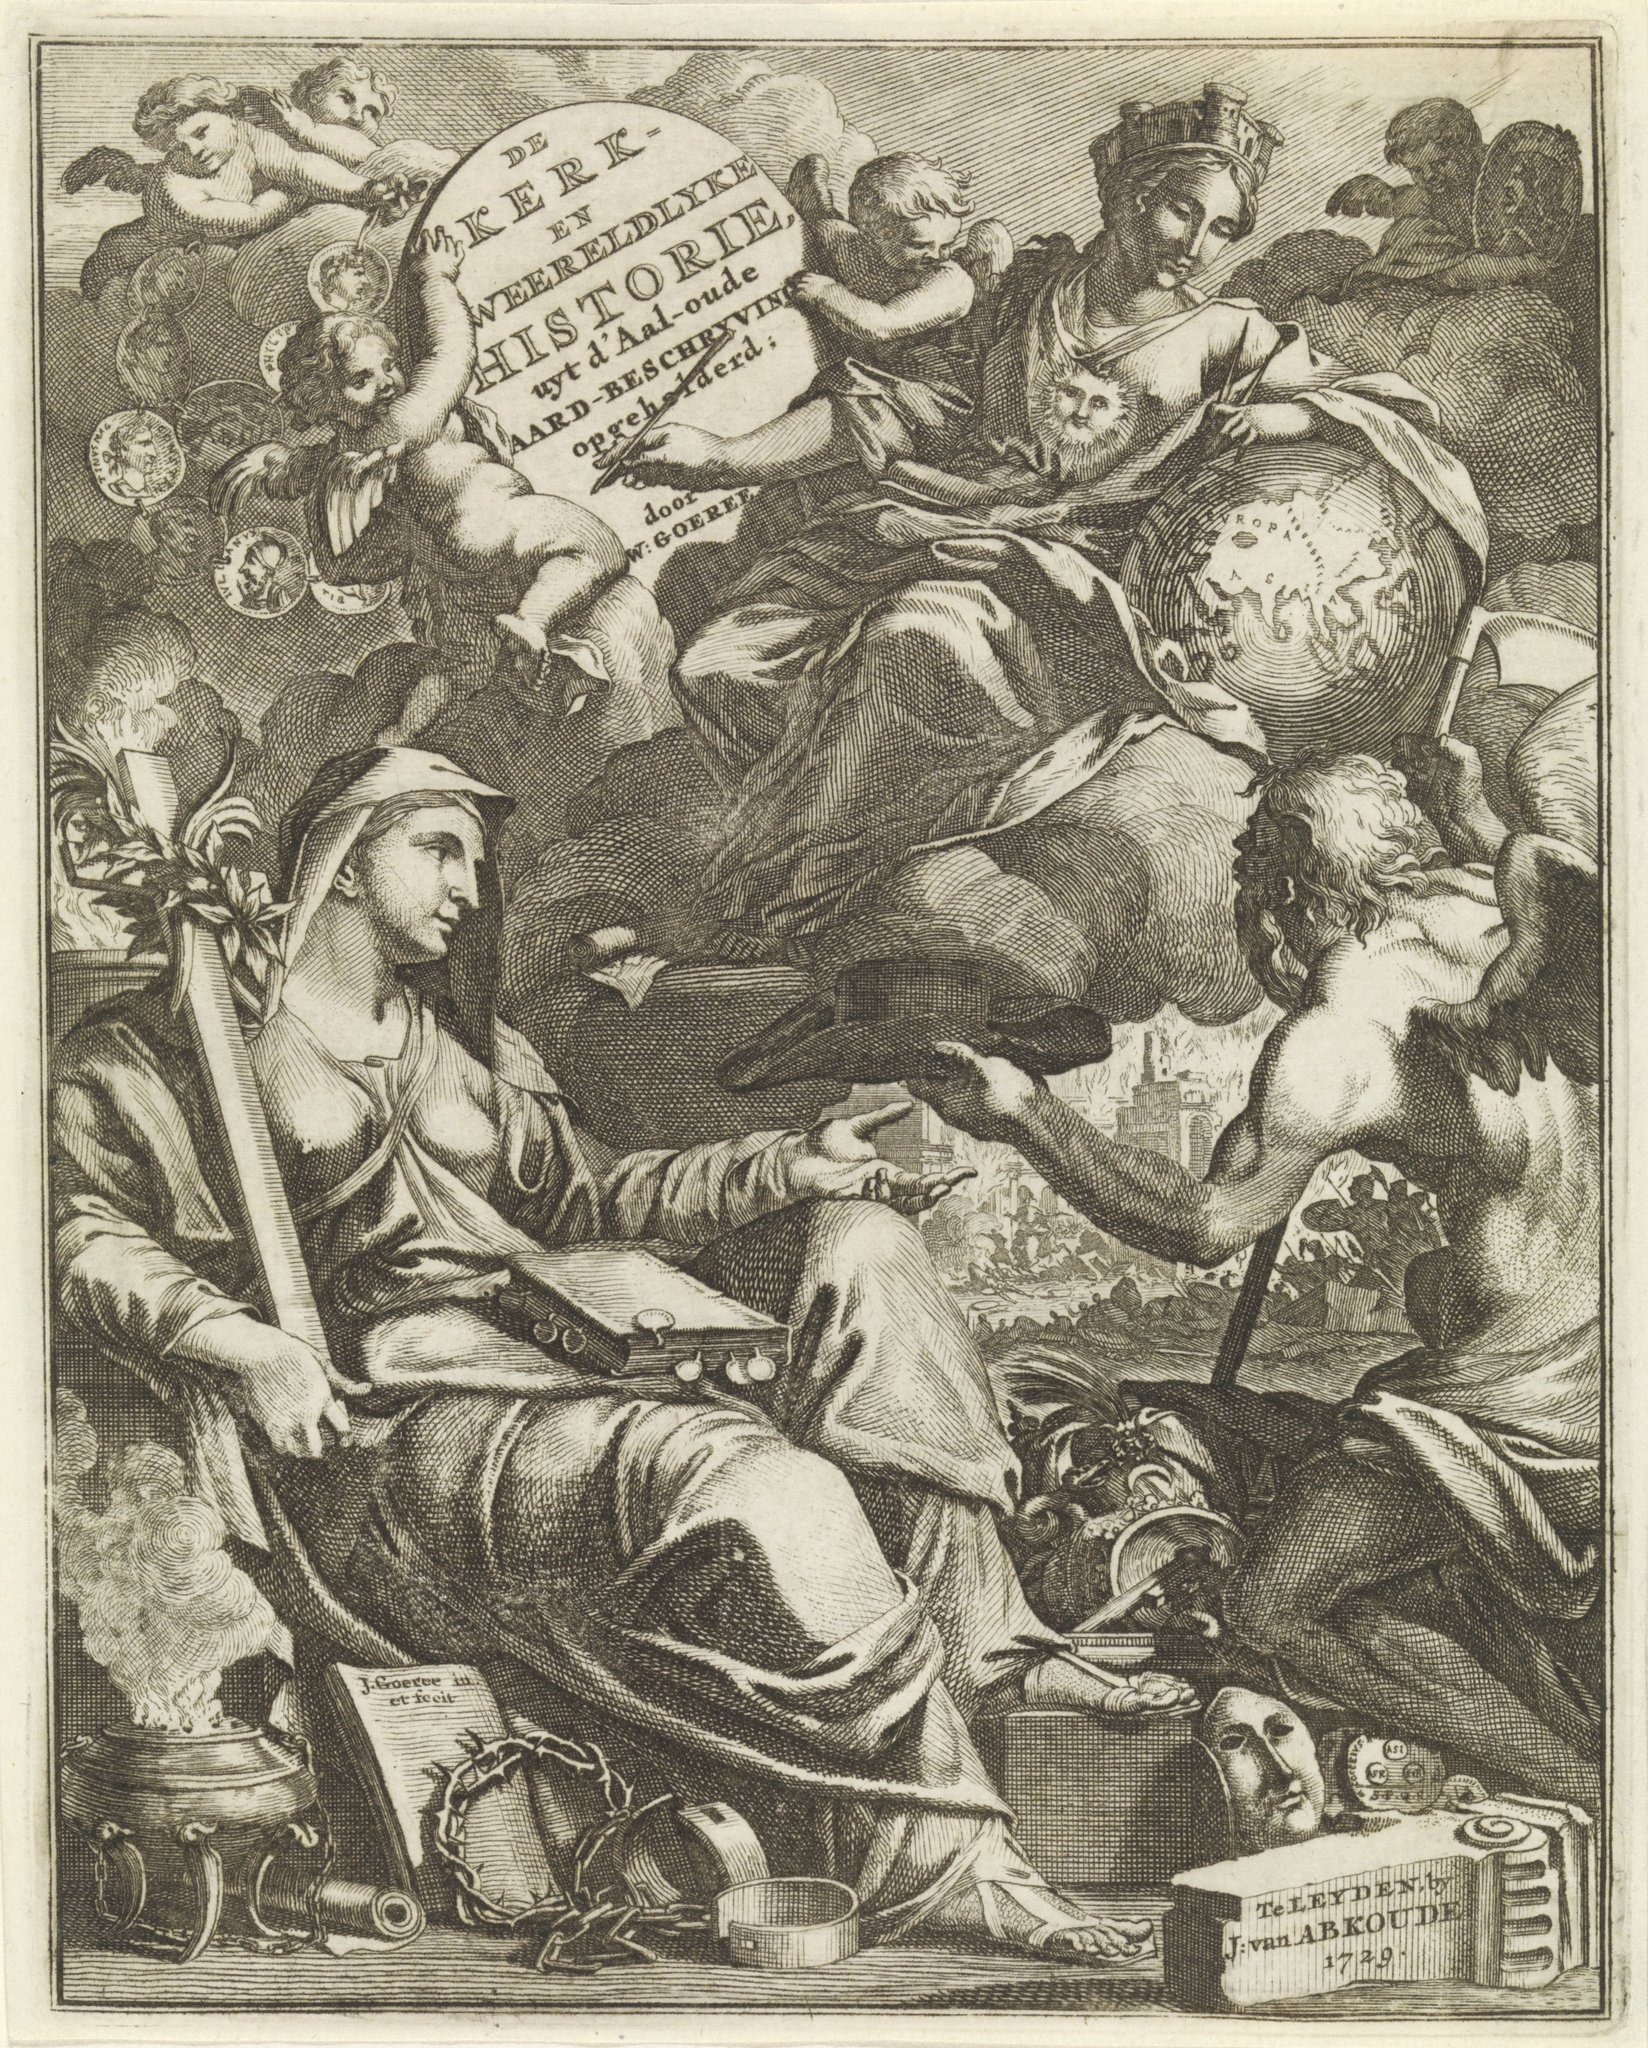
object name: print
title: Allegorie op de kerk- en wereldgeschiedenis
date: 1729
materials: paper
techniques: engraving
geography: amsterdam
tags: faith, 'fides'; 'fede', 'fede catholica', 'fede christiana', 'fede christiana catholica' (ripa) ~ one of the three theological virtues, battle, truth; 'verità' (ripa), father time, man with wings and scythe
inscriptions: date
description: In de wolken de personificatie Waarheid. In haar handen een wereldbol en een pen. Naast haar houden twee putti een medaillon omhoog met de titel van het boekwerk. Andere putti houden medaillons vast van personen uit de wereldgeschiedenis. Vadertje Tijd en de personificatie Geloof onder hen. De gevleugelde Tijd overhandigt een hoed (symbool voor trouw) aan Geloof. Op de achtergrond een veldslag.